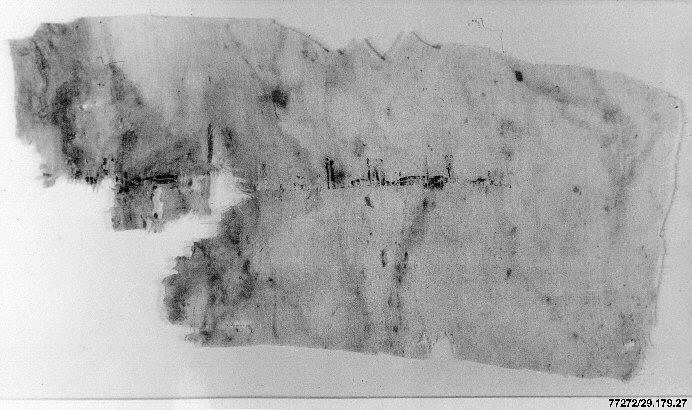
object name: textile fragment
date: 901-1000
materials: linen, silk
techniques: weave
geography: egypt